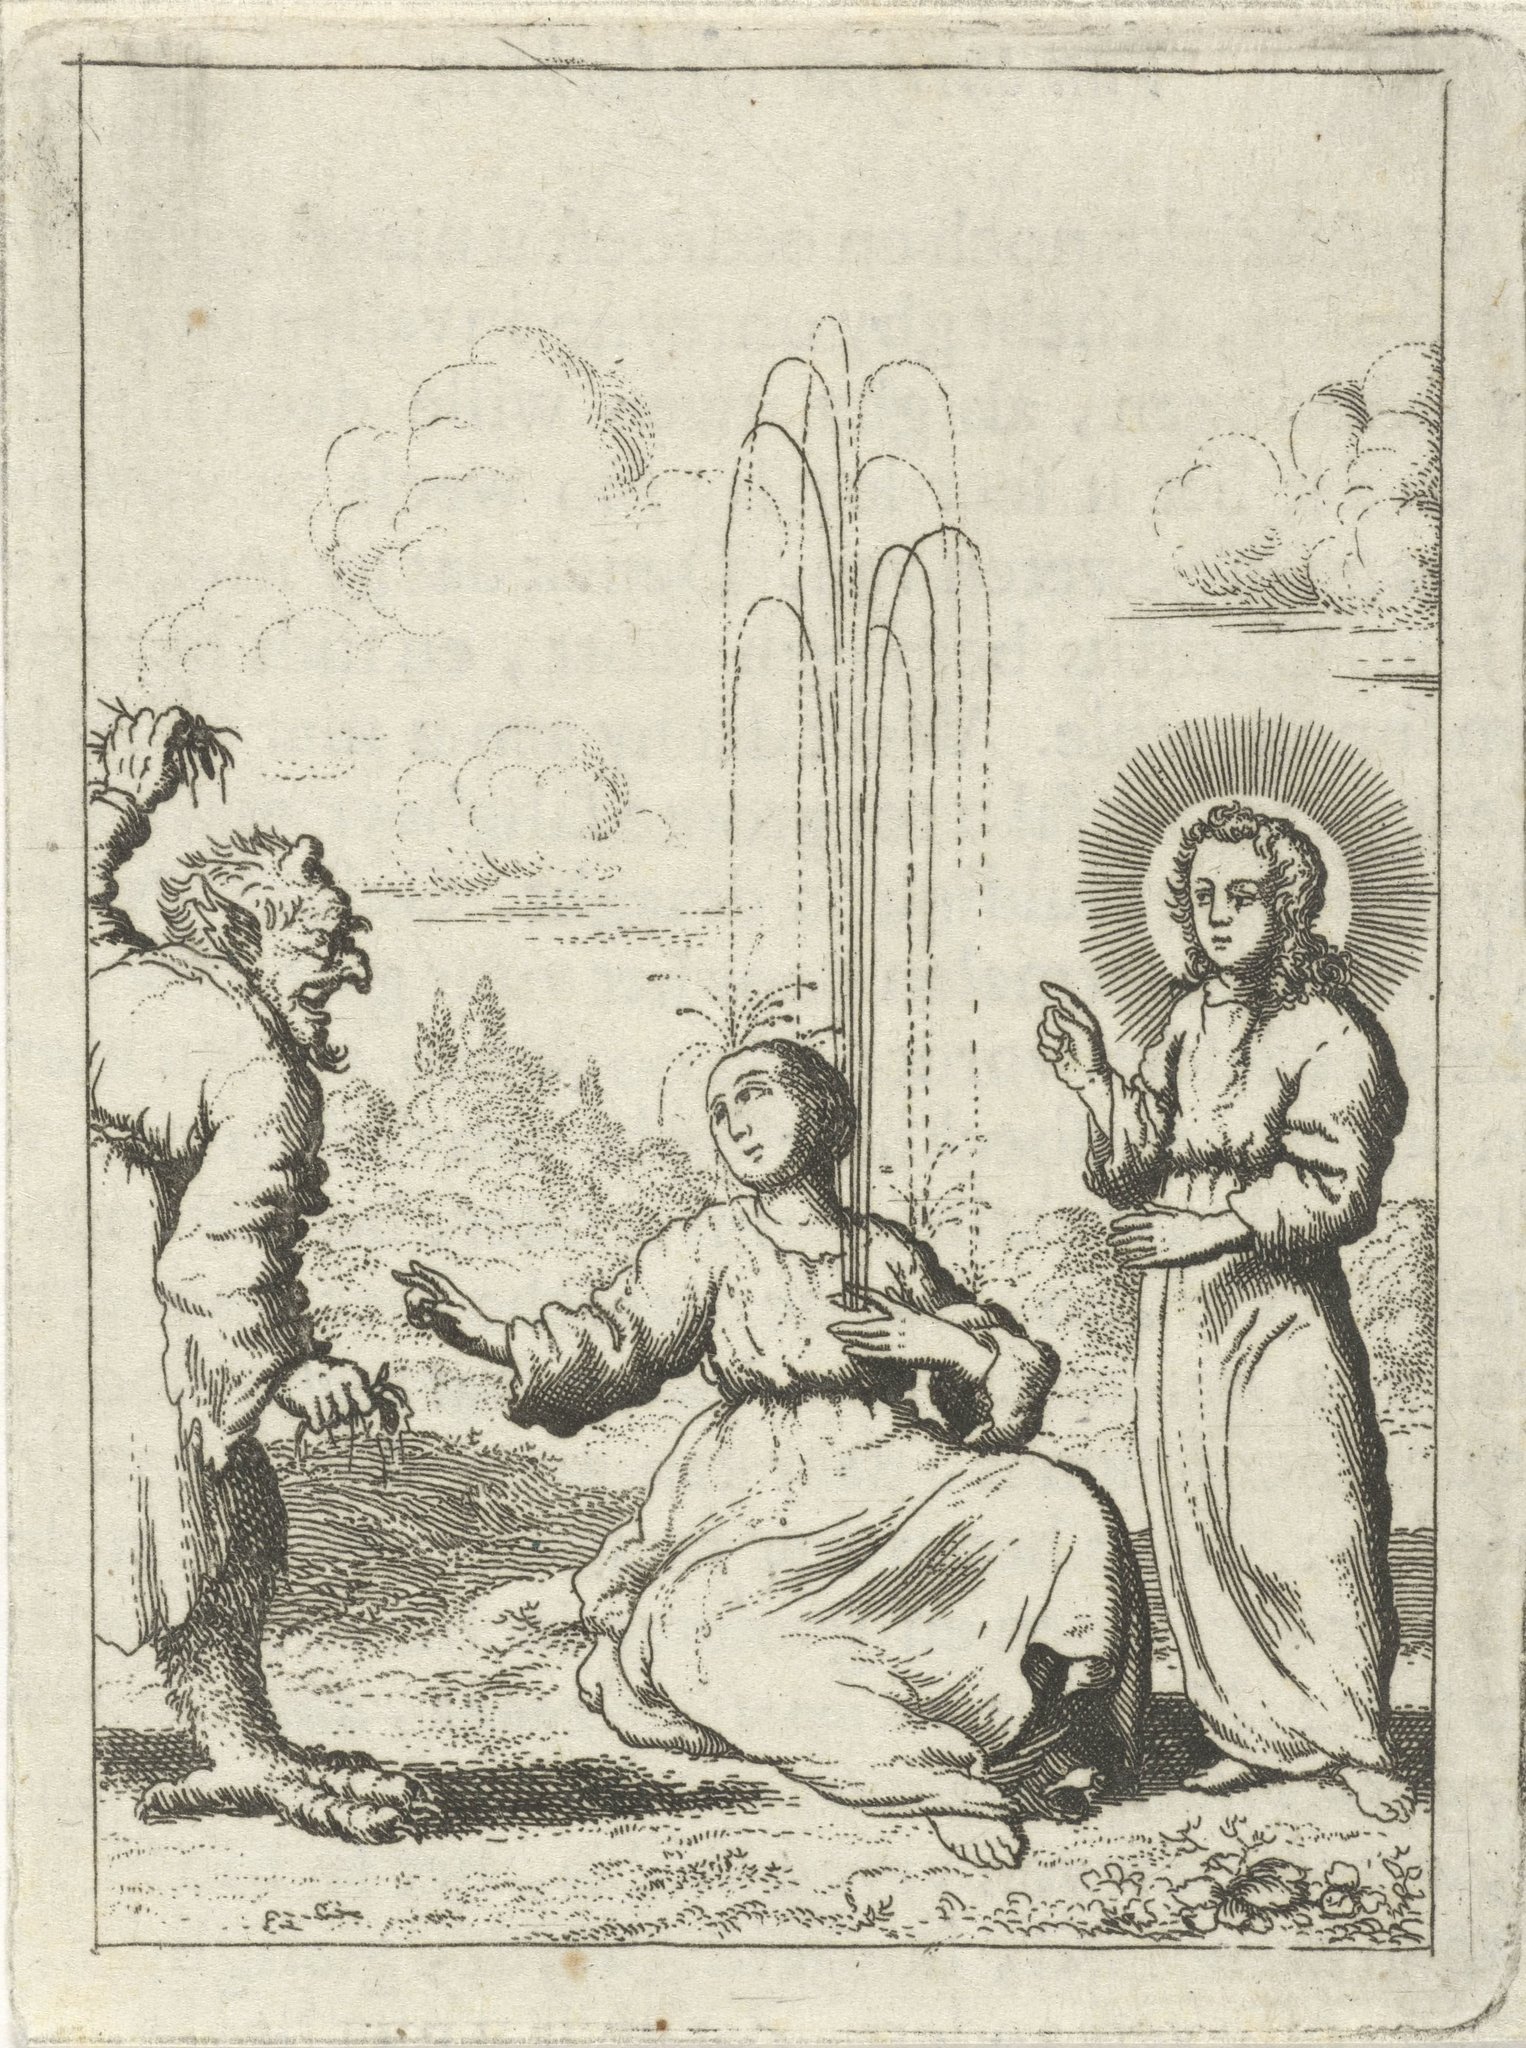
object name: print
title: Christus laat een fontein in het hart van de gepersonifieerde ziel ontspringen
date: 1678-1687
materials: paper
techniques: etching, letterpress printing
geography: amsterdam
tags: christ and the soul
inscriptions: collector's mark: Lugt 2228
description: Illustratie uit: Luyken, Jan. Jezus en de Ziel, 3 delen. Amsterdam: Pieter Arentsz II, 1678-1687. Tussen 1678-1744 verschenen van dit emblemataboek 10 edities.